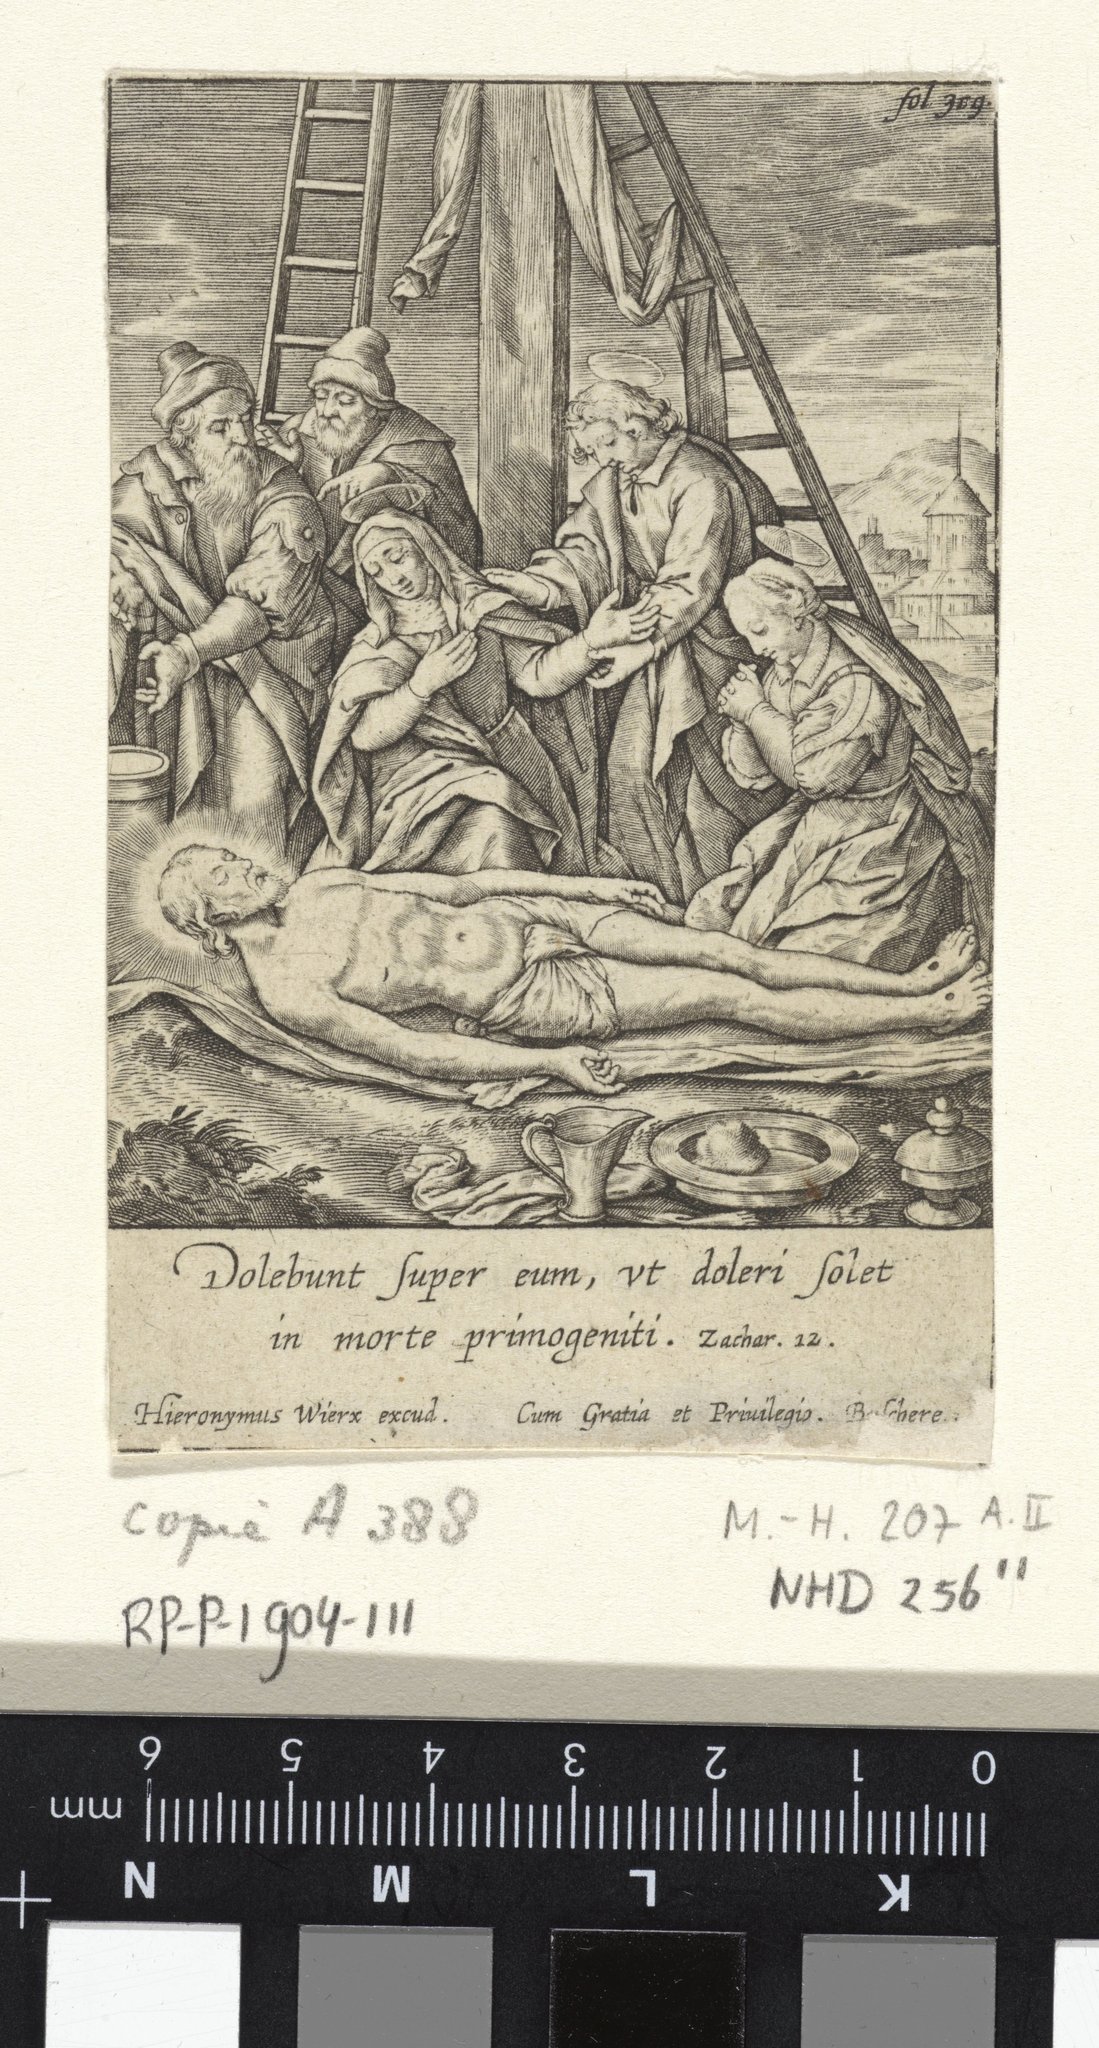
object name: print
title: Bewening van Christus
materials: paper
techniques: engraving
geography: antwerp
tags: christ's body lying on the ground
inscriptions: collector's mark: Lugt 2228, monogram: ‘HR MC Z’, inscription: ‘Opsomming van negen regels van de figuren in de voorstelling.’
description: Maria, Maria Magdalena en Johannes de Evangelist, en anderen, treuren bij het lichaam van Christus. Christus ligt op een lijkwade aan de voet van het kruis. In de marge een tweeregelig Bijbelcitaat uit Zach. 12 in het Latijn. Rechtsboven gemerkt: fol. 309.